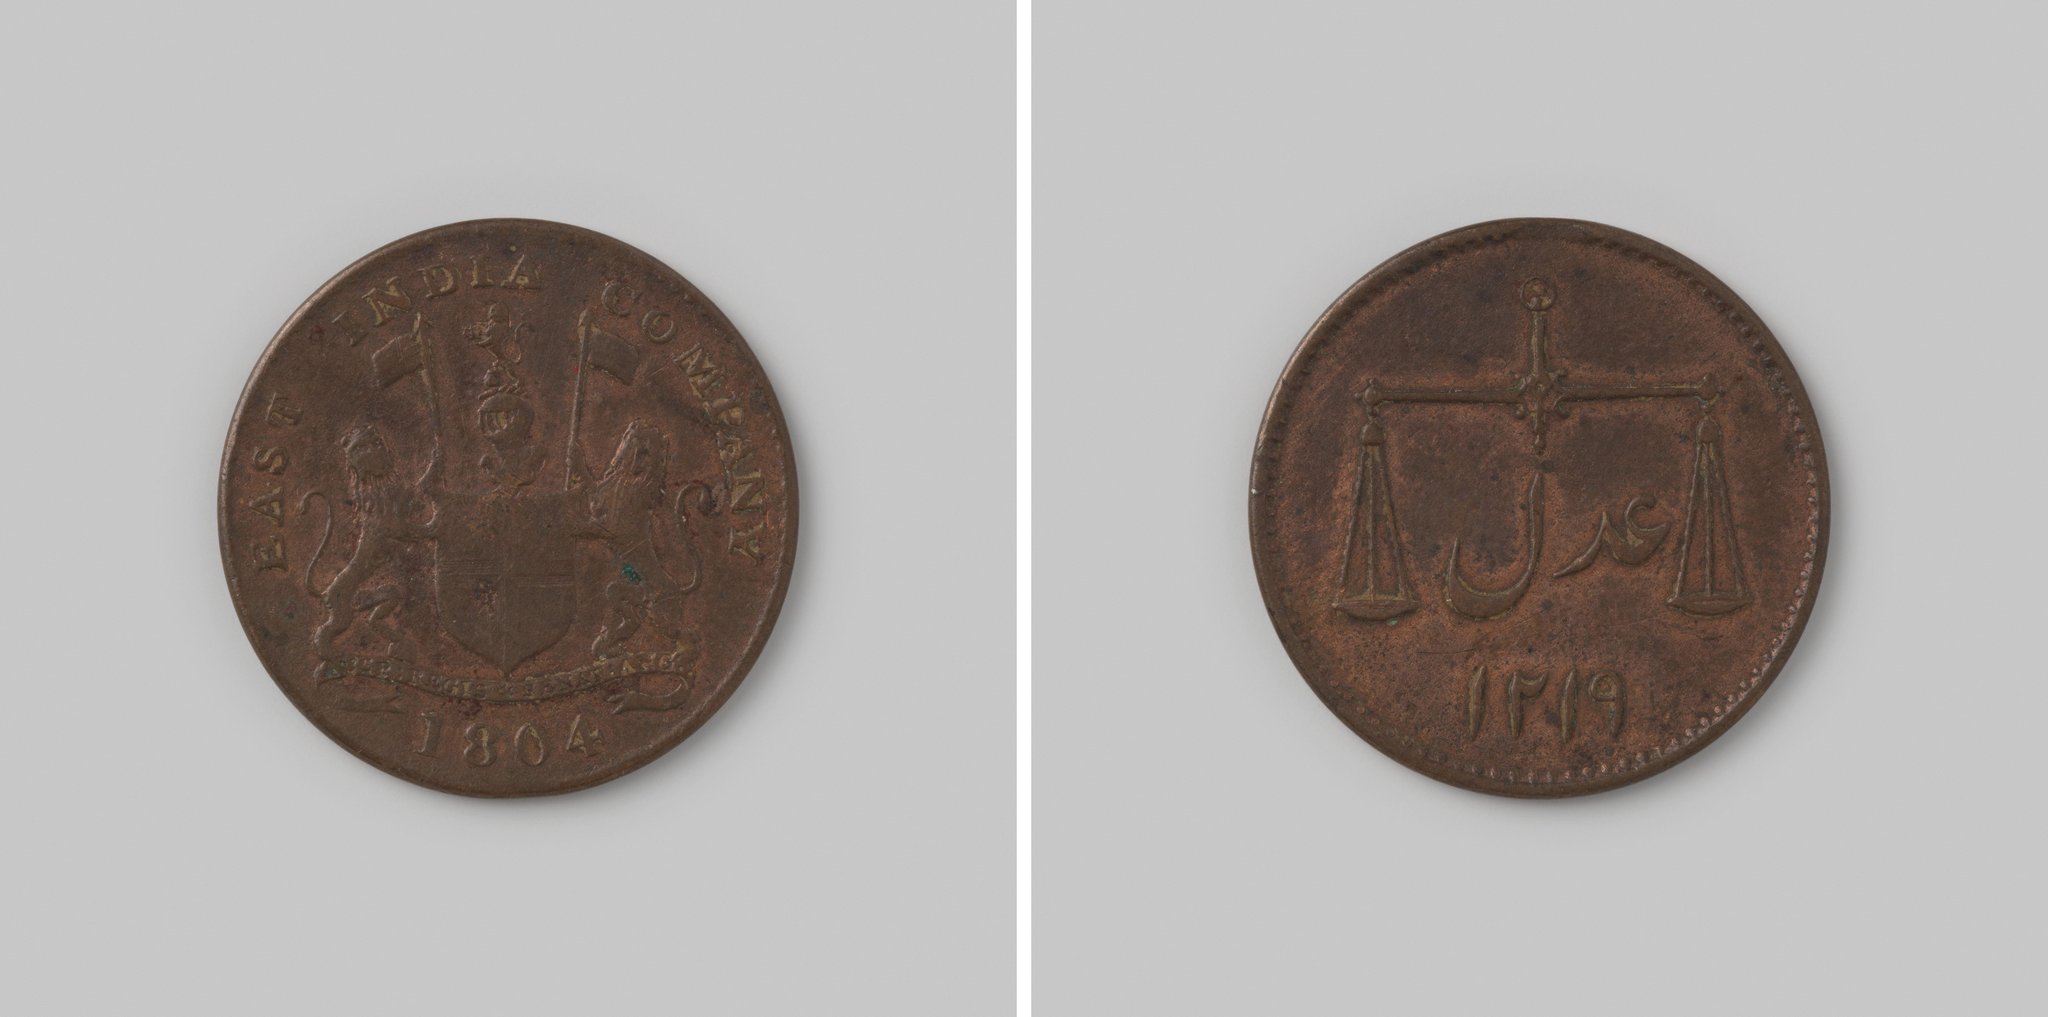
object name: coin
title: Bombay, India, Engelse Oostindische Compagnie (EIC) , ½ pice voor Bombay, India, 1219, 1804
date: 1804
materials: copper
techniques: striking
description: Koperen munt. Voorzijde: door twee op banderol, waarin opschrift, staande leeuwen met pijl, waaraan vlag, in de klauw, gehouden wapenschild van de EIC, waarboven helmteken. Jaartal onderaan. Keerzijde: weegschaal, waartussen in Arabische lettertekens opschrift: Adil en waaronder jaartal: 1219 [=1804]. Gladde rand. Geslagen in Engeland.